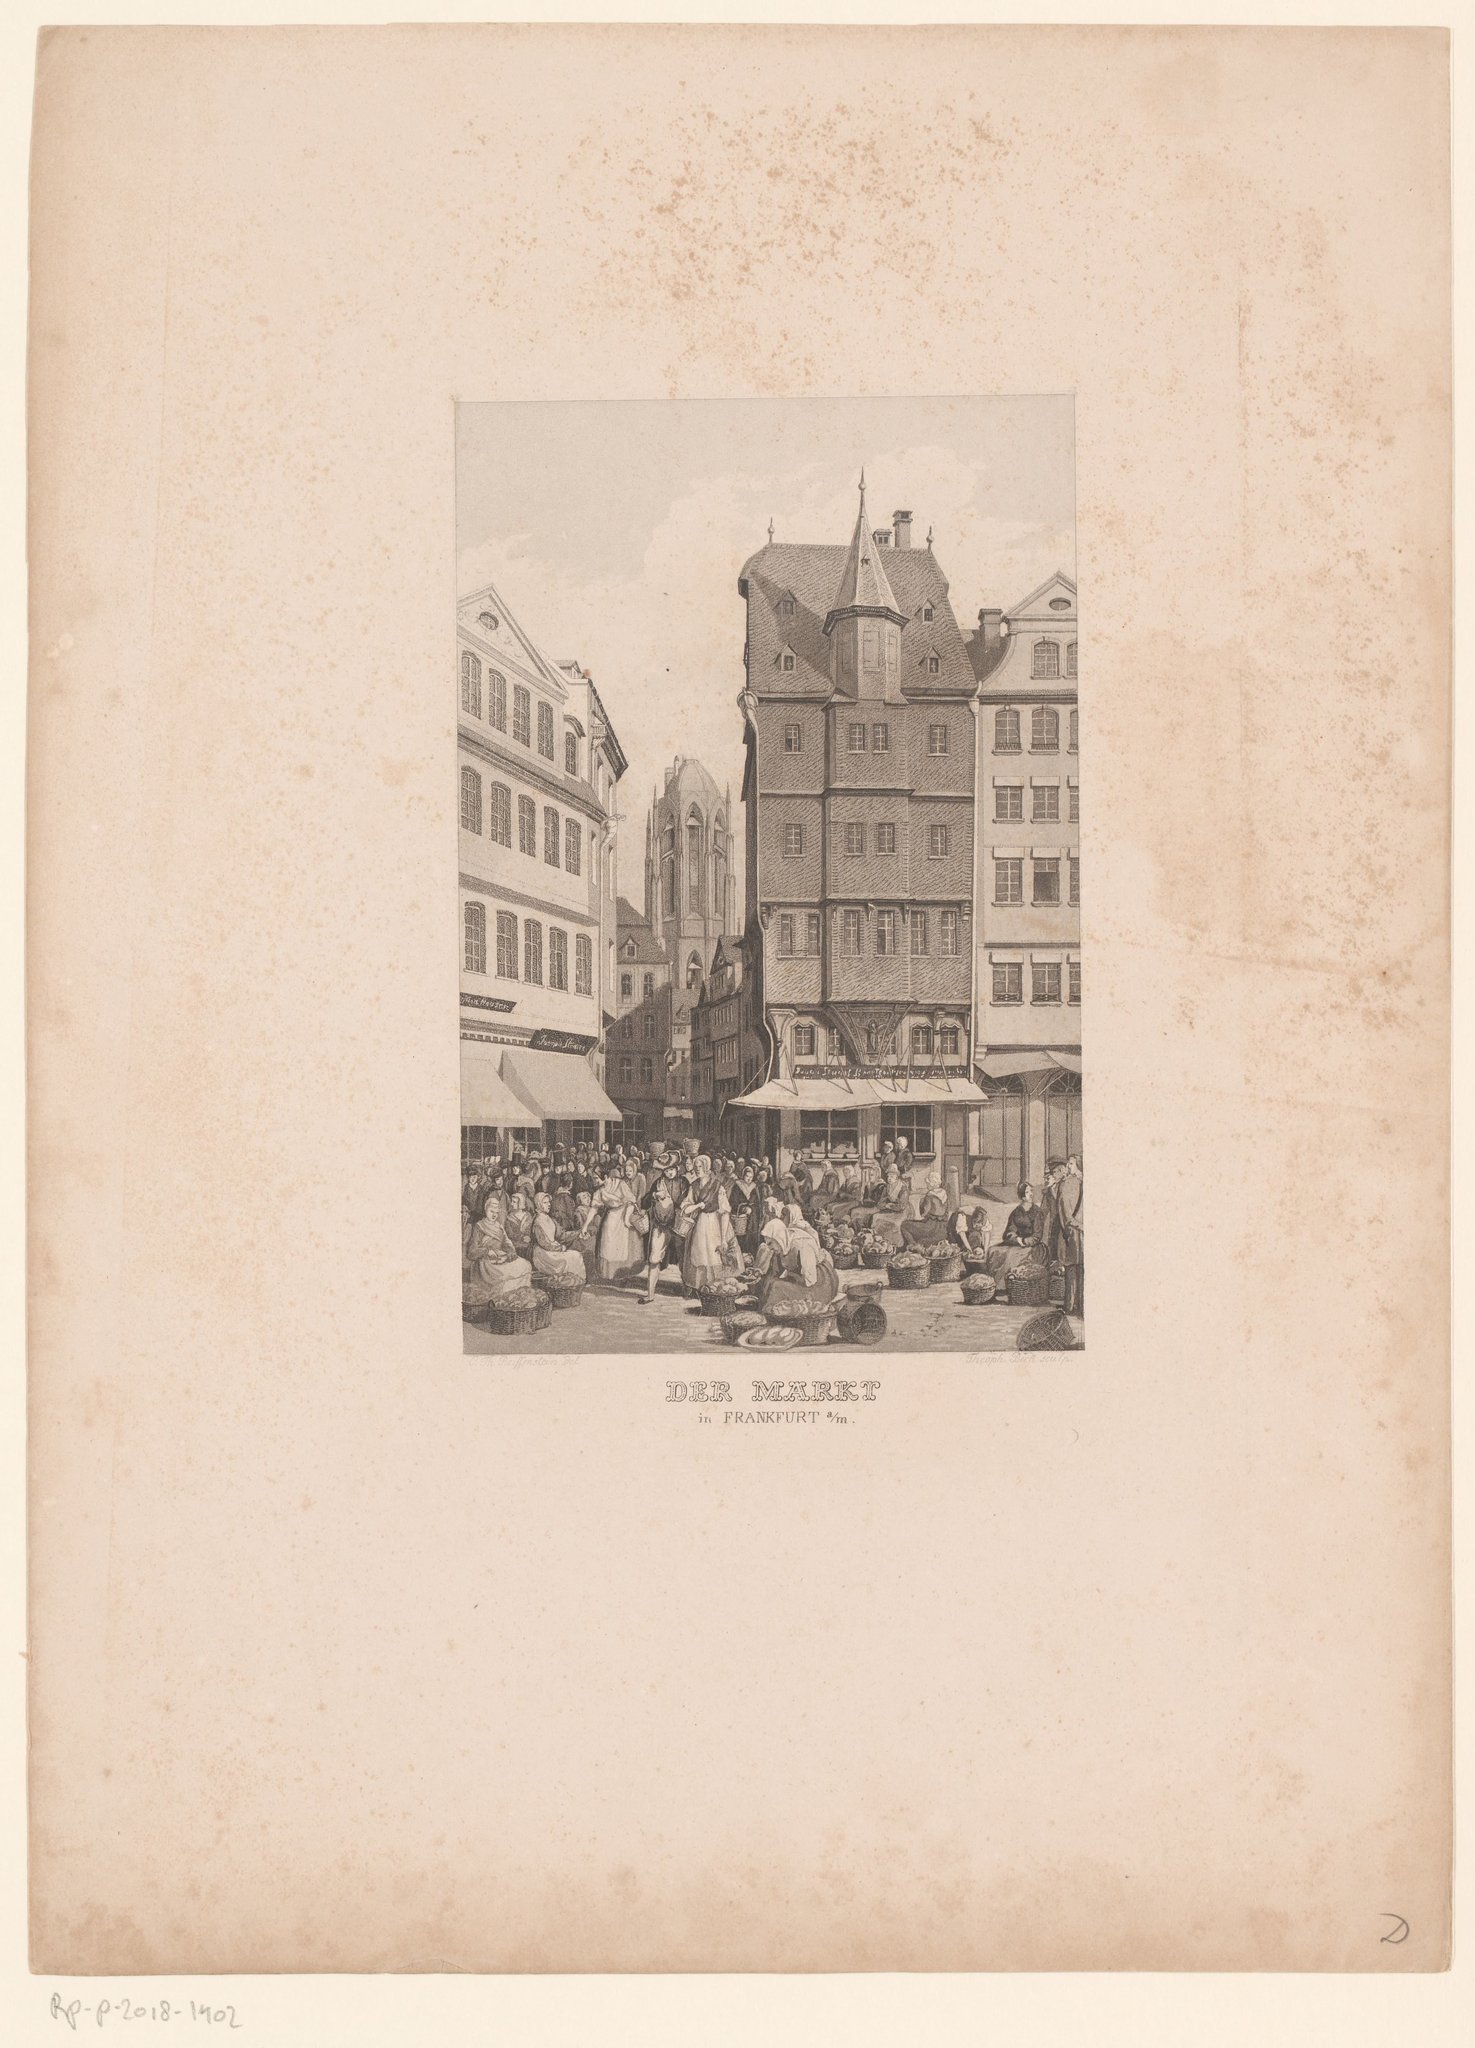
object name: print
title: Gezicht op het huis genaamd Großer Engel te Frankfurt am Main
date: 1843-1903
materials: paper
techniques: aquatint, etching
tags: church (exterior), market, façade (of house or building)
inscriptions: collector's mark: Lugt 2228